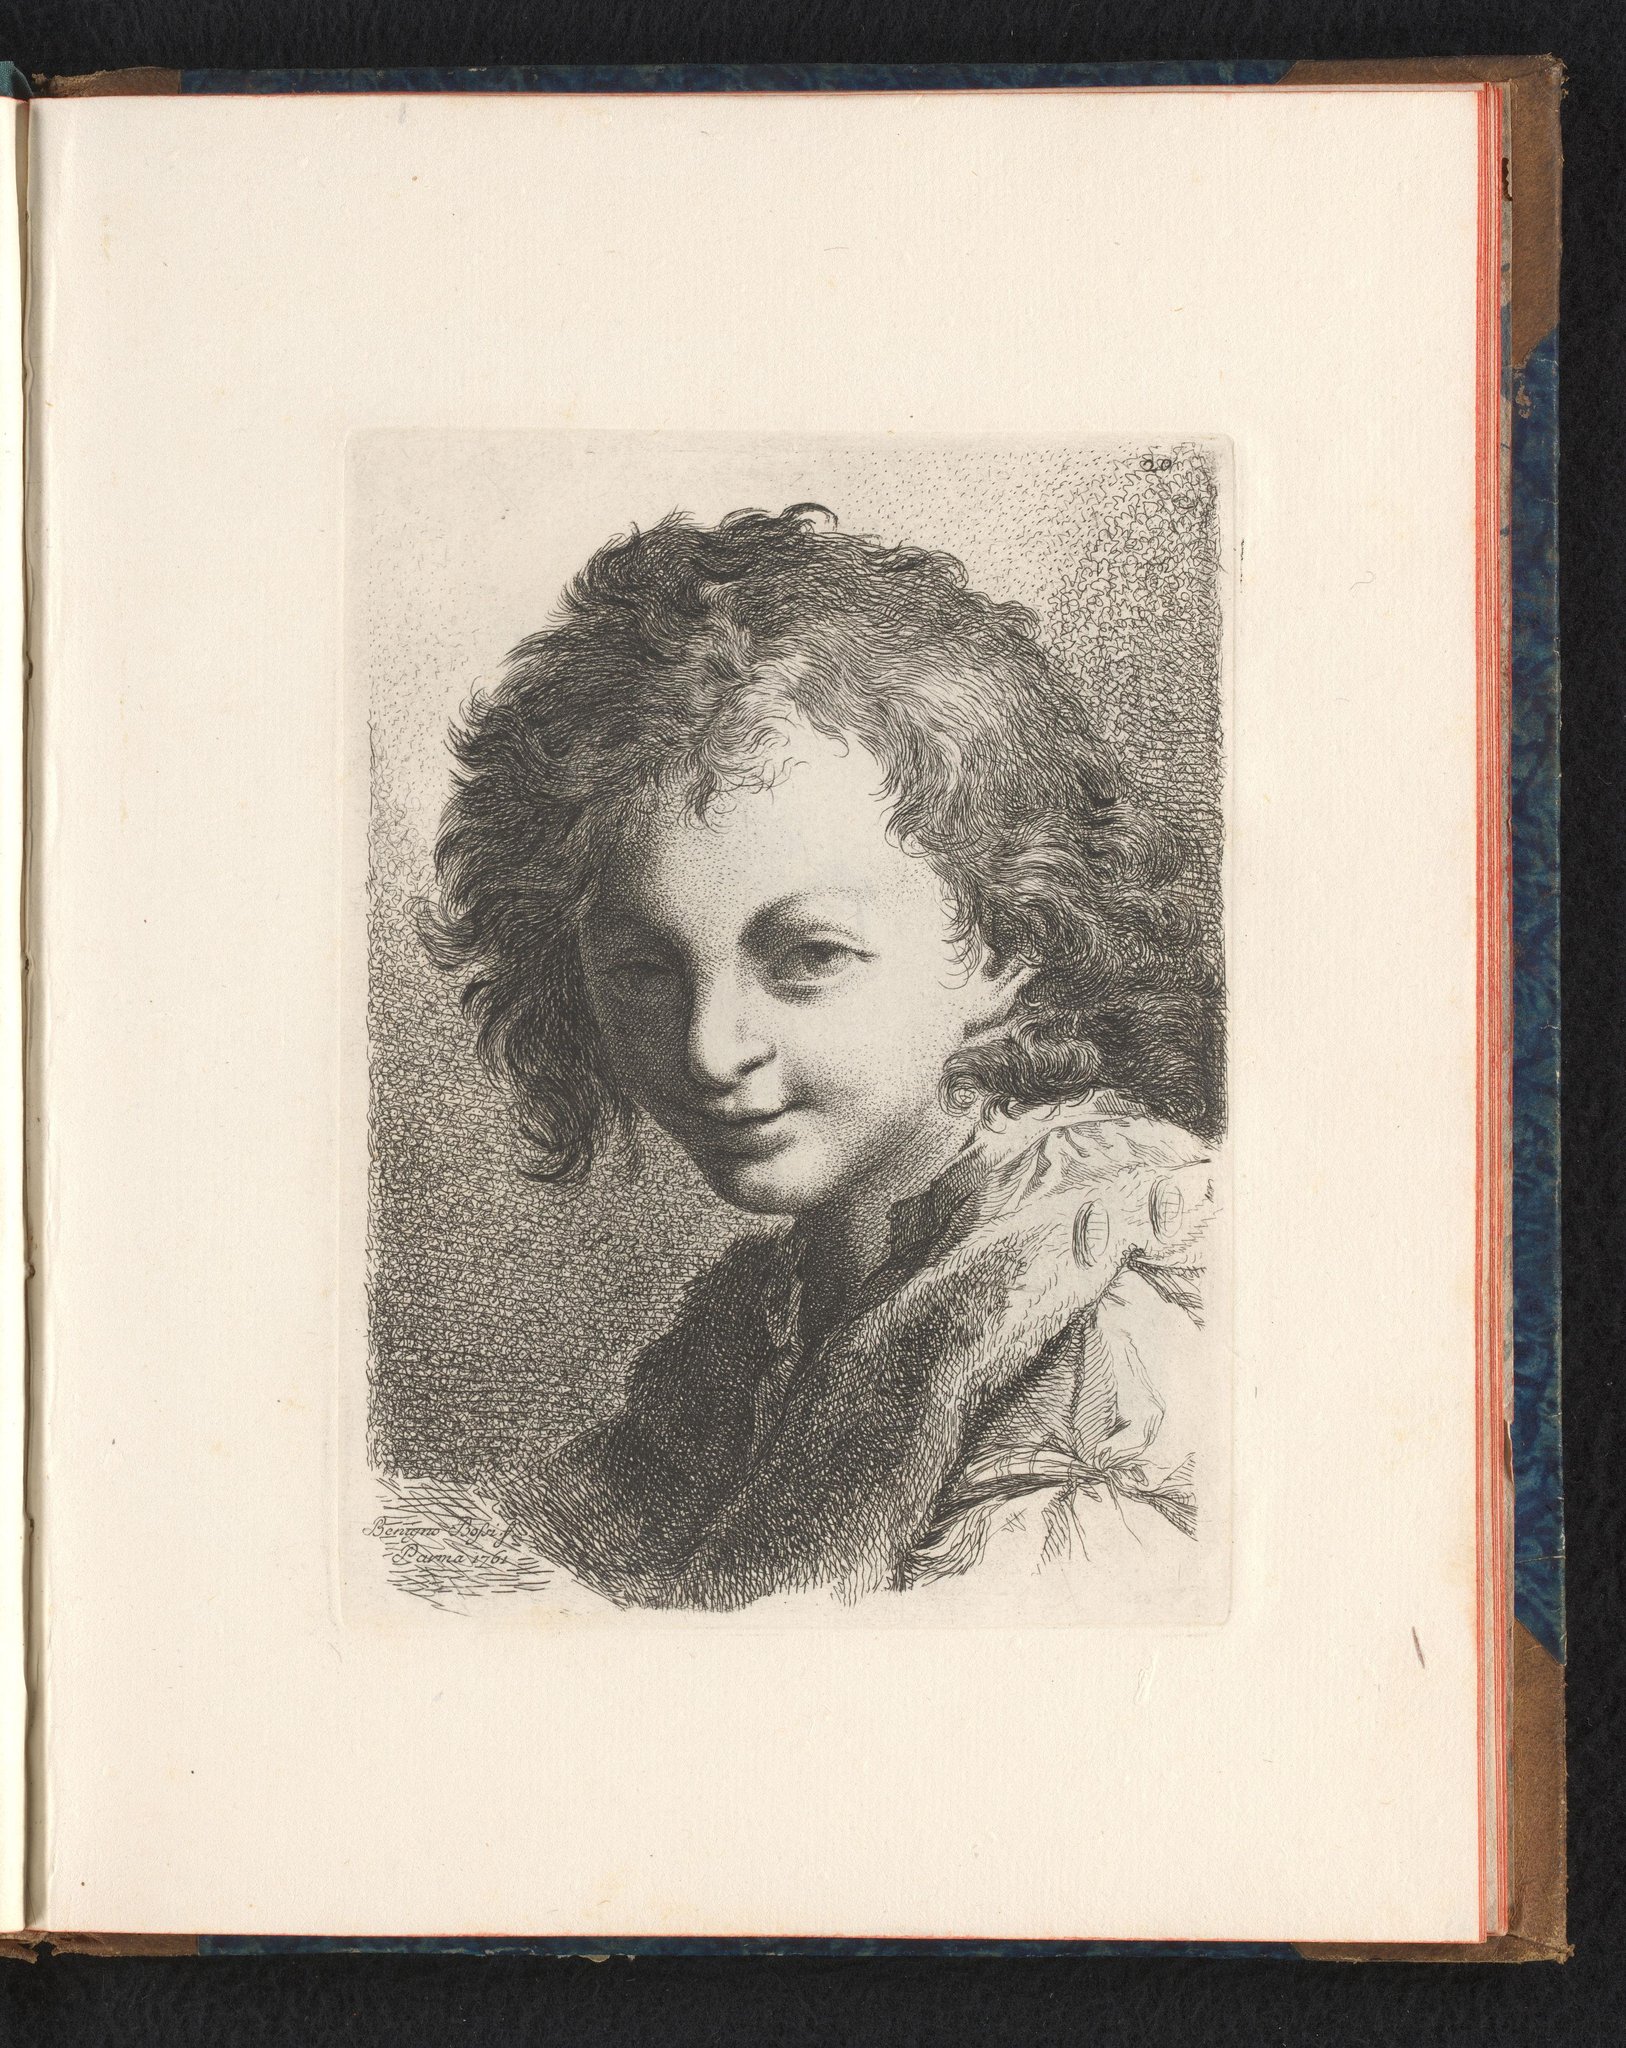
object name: album leaf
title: Verzameling van hoofden, gedachten, trofeeën en diverse etsen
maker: benigno bossi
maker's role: print maker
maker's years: 1727-1792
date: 1761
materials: paper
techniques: etching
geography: parma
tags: the (nude) human figure; 'corpo humano' (ripa), youth, adolescent